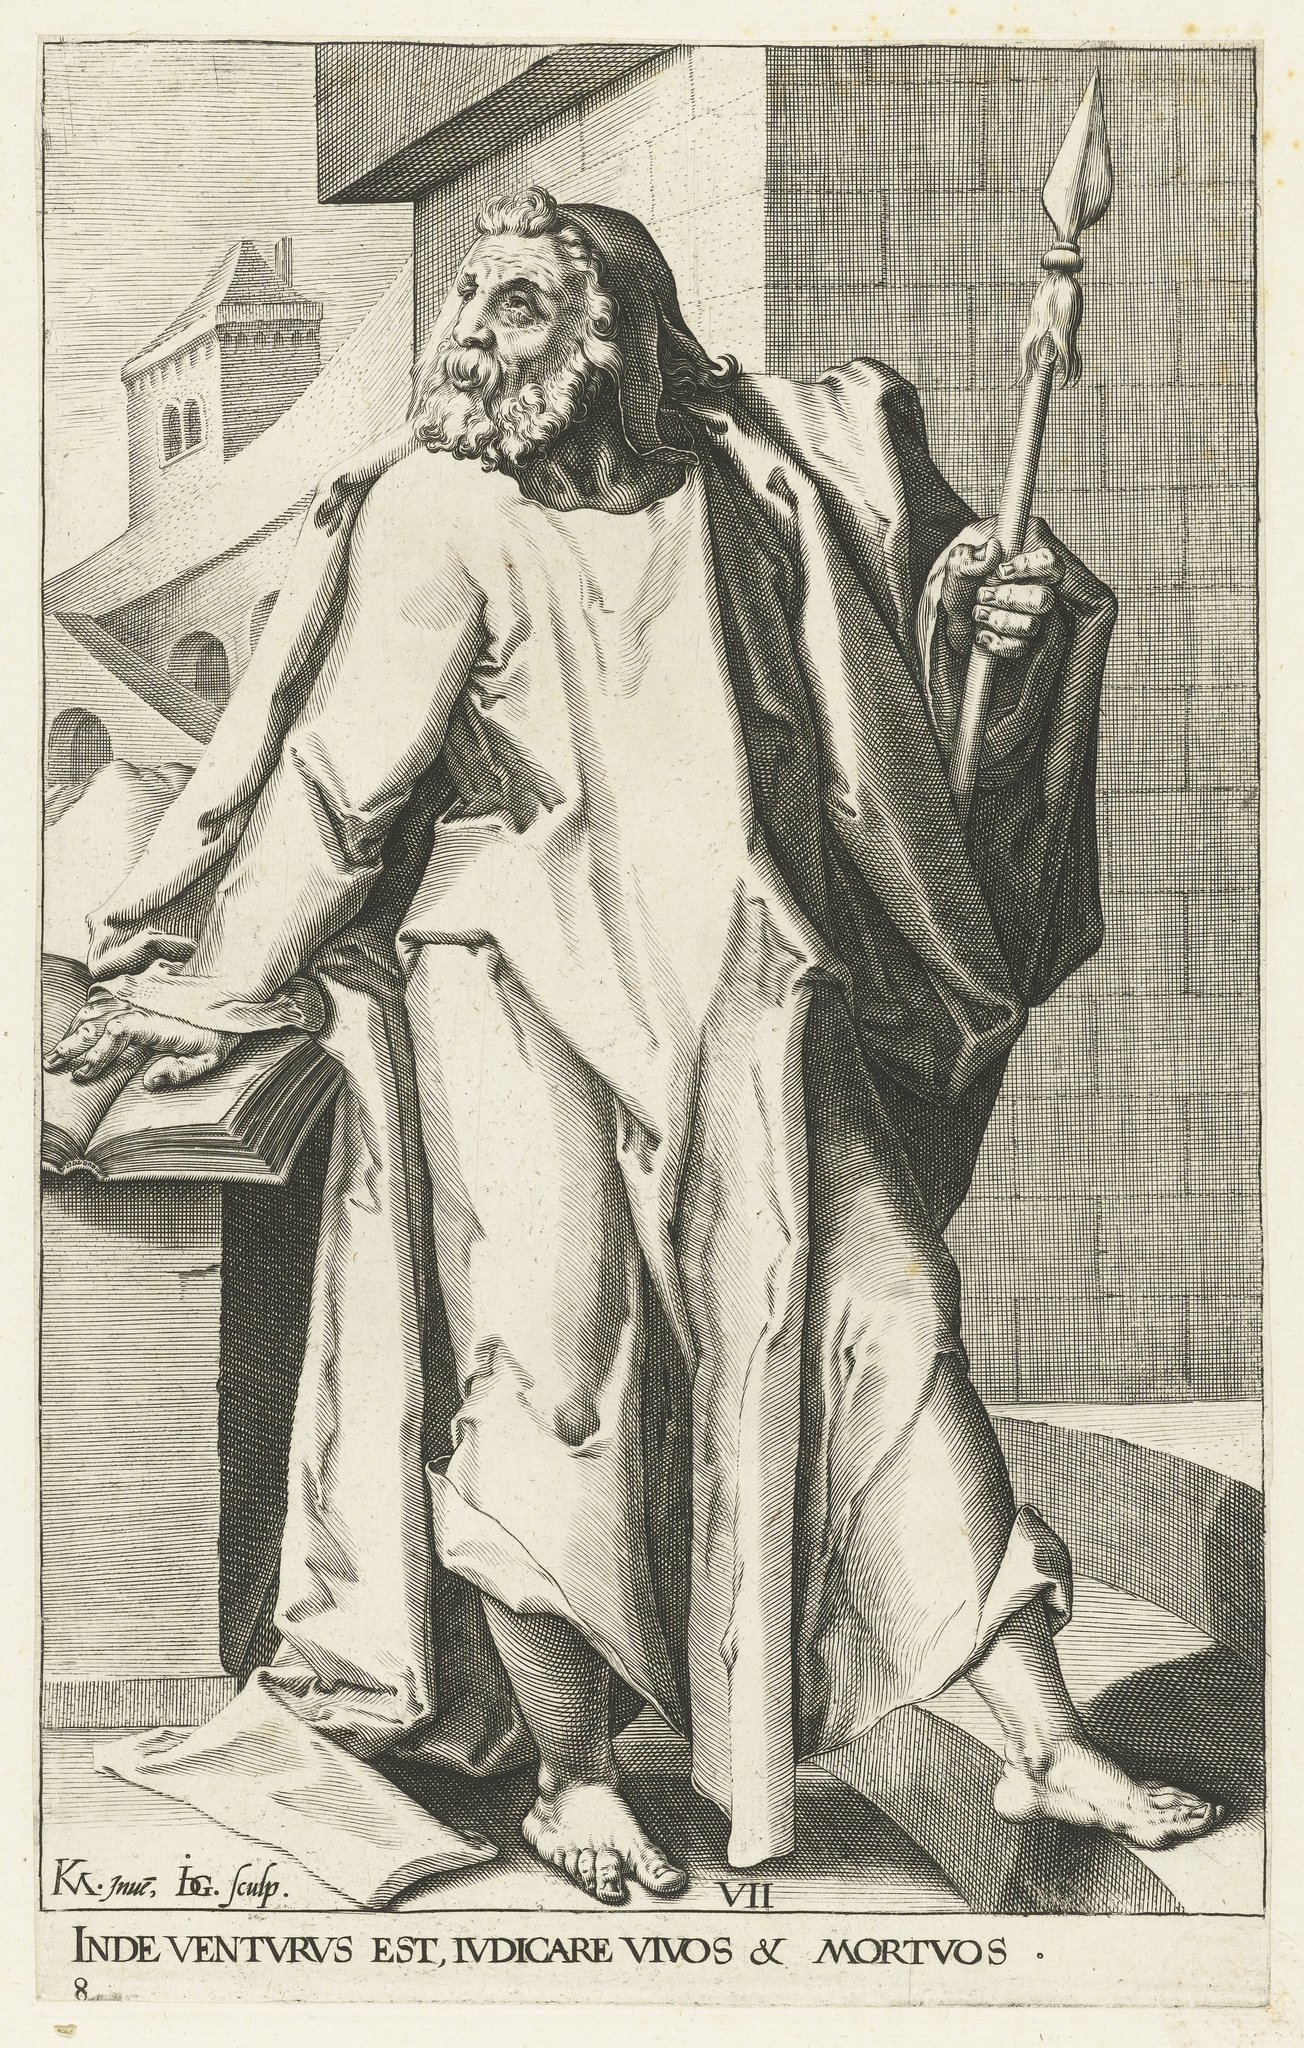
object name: print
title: Christus, de twaalf apostelen en de heilige Paulus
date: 1591-1592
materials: paper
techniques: engraving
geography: amsterdam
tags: the apostle thomas; possible attributes: book, chalice, girdle, heart, lance or spear, scroll, square, stones, 'inde venturus est iudicare vivos et mortuos' ~ articles of faith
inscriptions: collector's mark: Lugt 240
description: De apostel Thomas, staand op een trap bij een gebouw, de rechterhand op een boek, in de linkerhand een speer. Onder de voorstelling een regel Latijnse tekst. Deze prent is onderdeel van een serie van 14 prenten, elk bestaand uit een beeltenis ten voeten uit van een apostel, Christus of Paulus met typerende attributen en een onderschrift in Latijn.